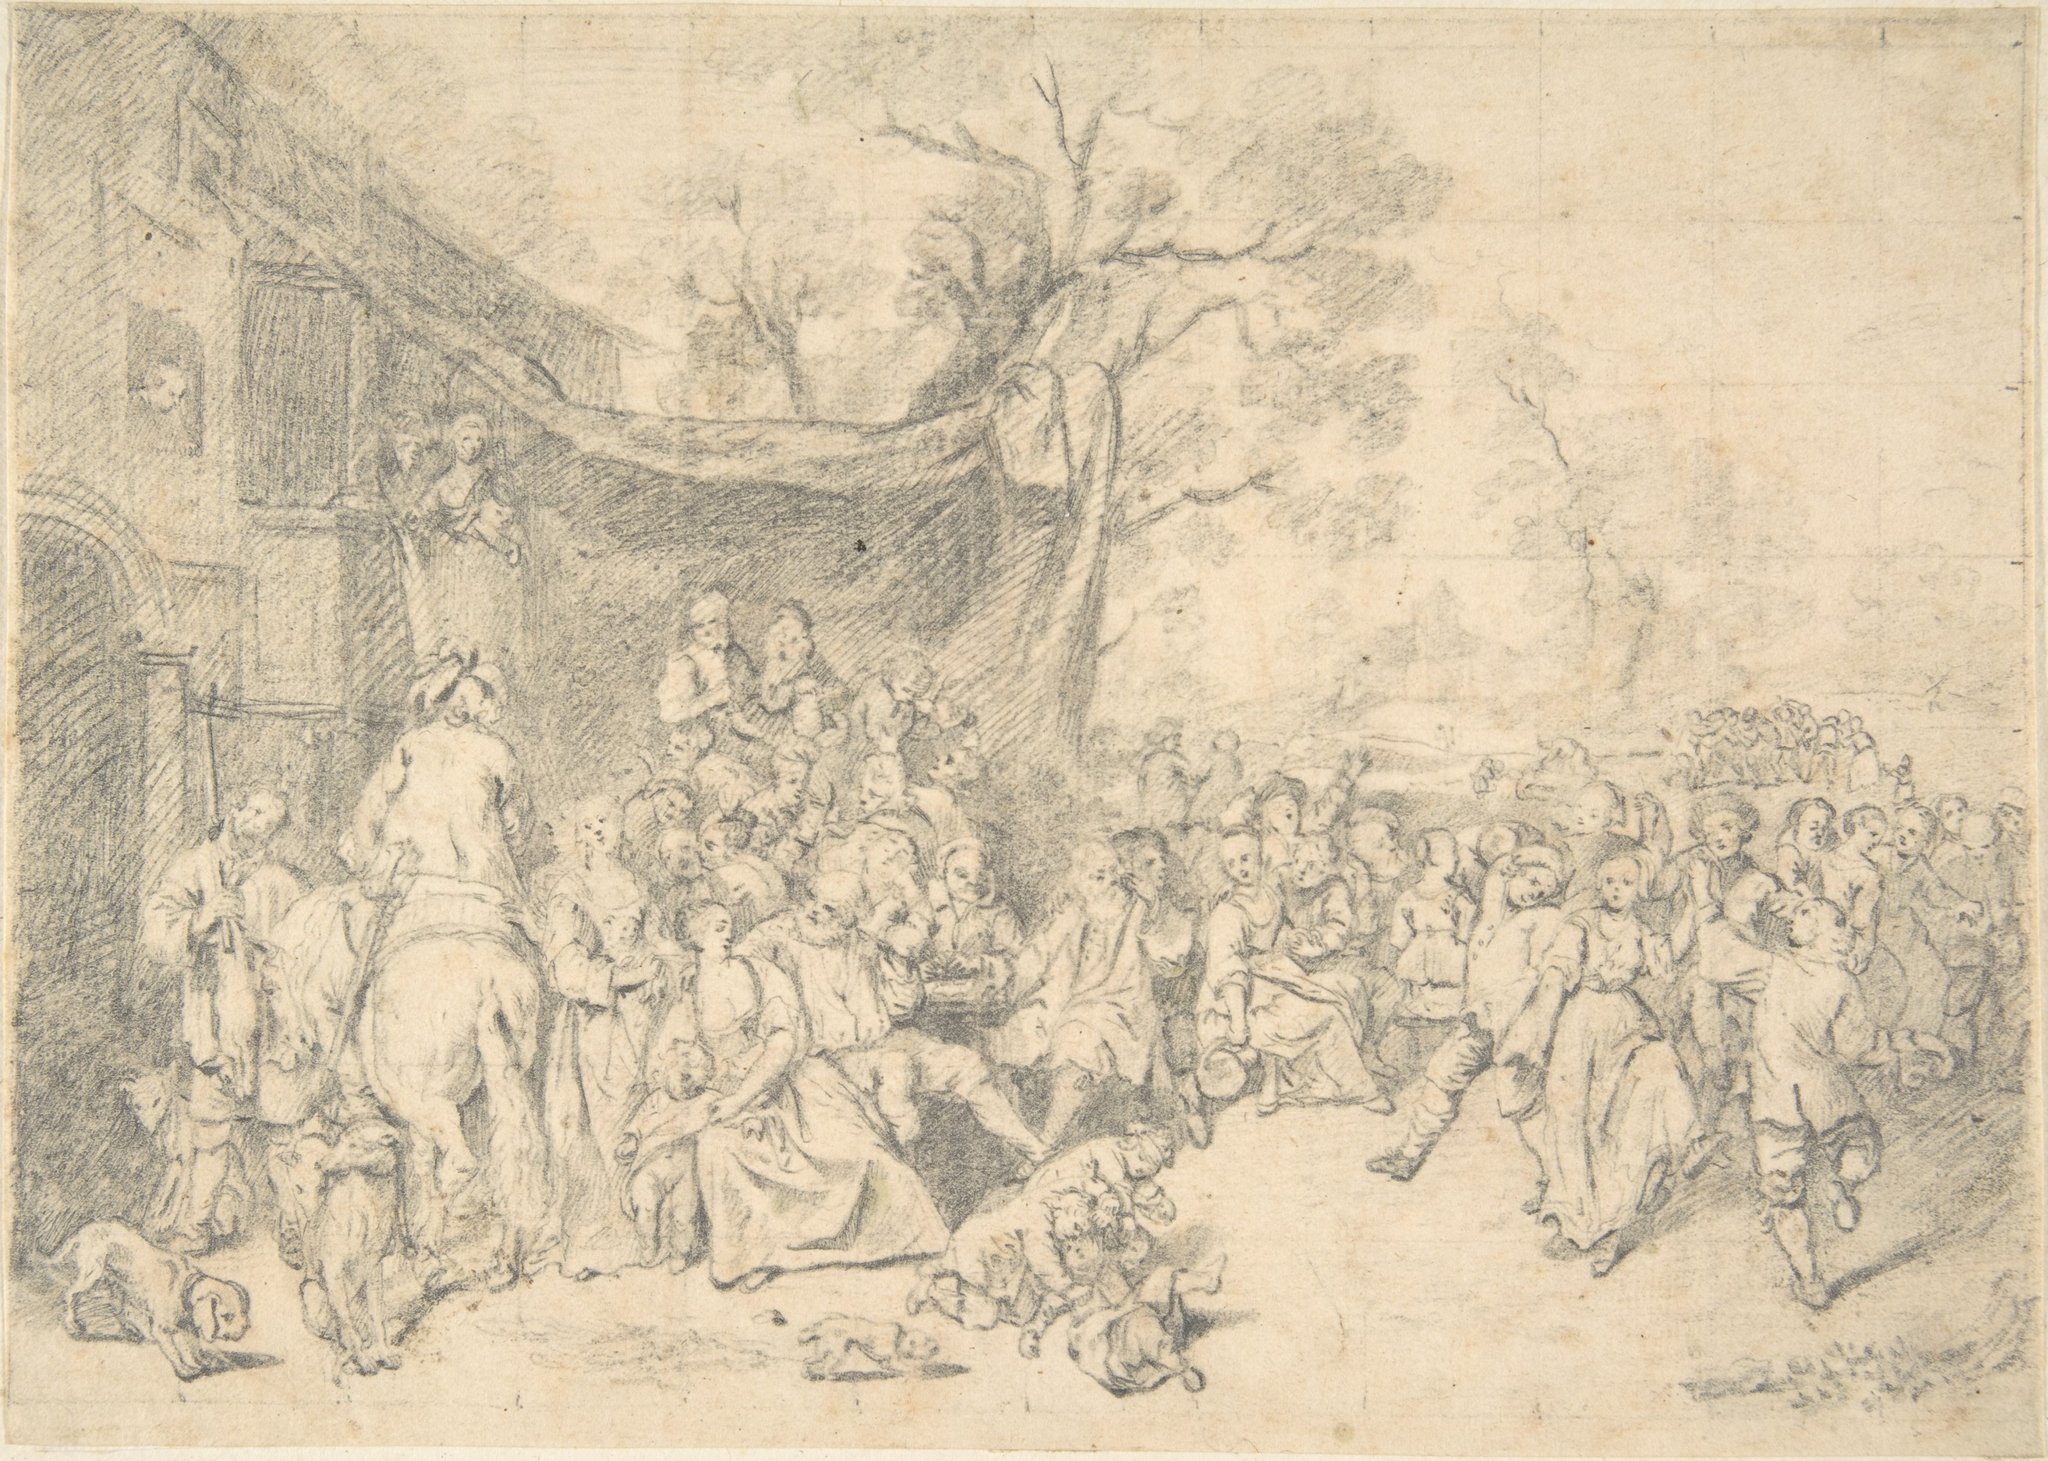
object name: drawing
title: Peasants' Dance Outdoors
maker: karl friedrich wilhelm richard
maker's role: artist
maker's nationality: german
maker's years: 1725-1770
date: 1745-1770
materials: down, graphite, paper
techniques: drawing, transfer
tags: dance,boys,girls,men,dancers